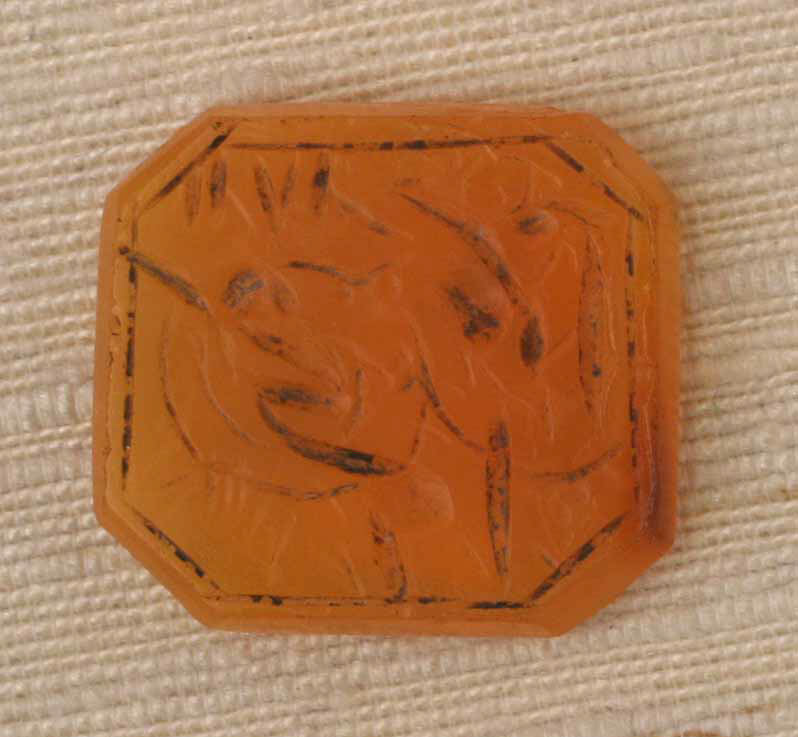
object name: stamp seal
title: Seal Stamp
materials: stone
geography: iran